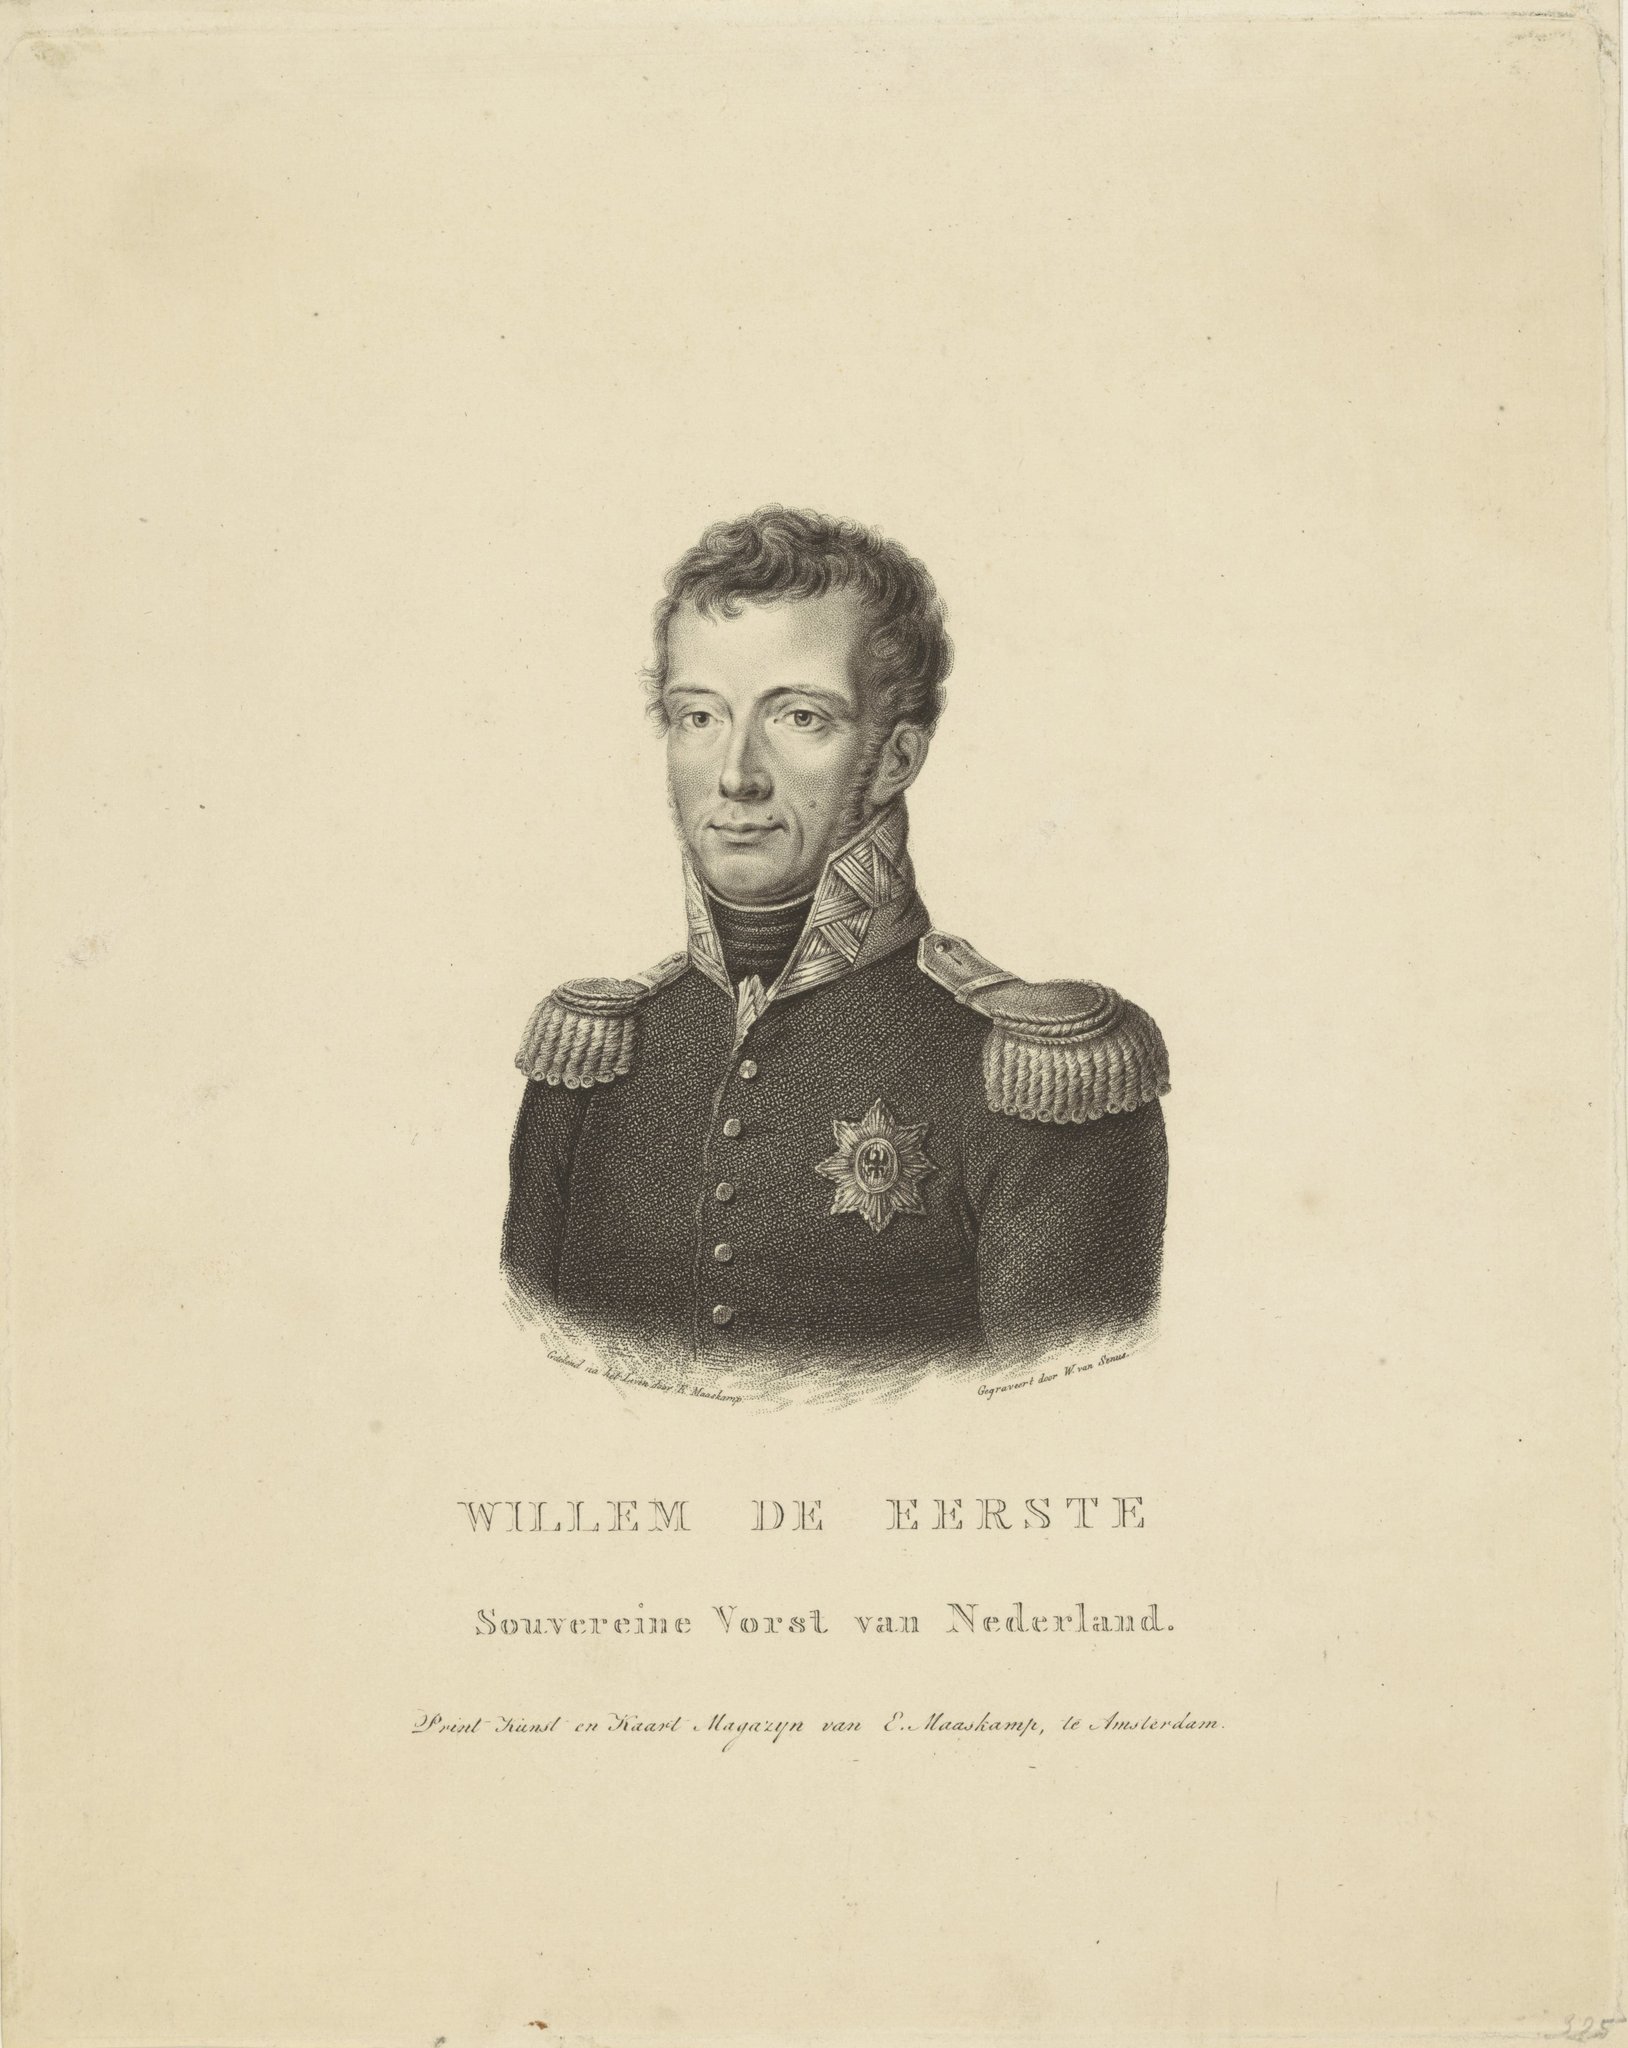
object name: print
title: Portret van Willem I Frederik, koning der Nederlanden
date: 1813-1815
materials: paper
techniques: engraving, etching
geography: amsterdam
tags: the hague, berlin, william i of the netherlands, knighthood order (with name) - insignia of a knighthood order, e.g.: badge, chain (with name of order)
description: De hier vermelde titel verwijst naar de hoogst verkregen titel van de geportretteerde, niet per se naar de titel die de geportretteerde op deze voorstelling draagt.